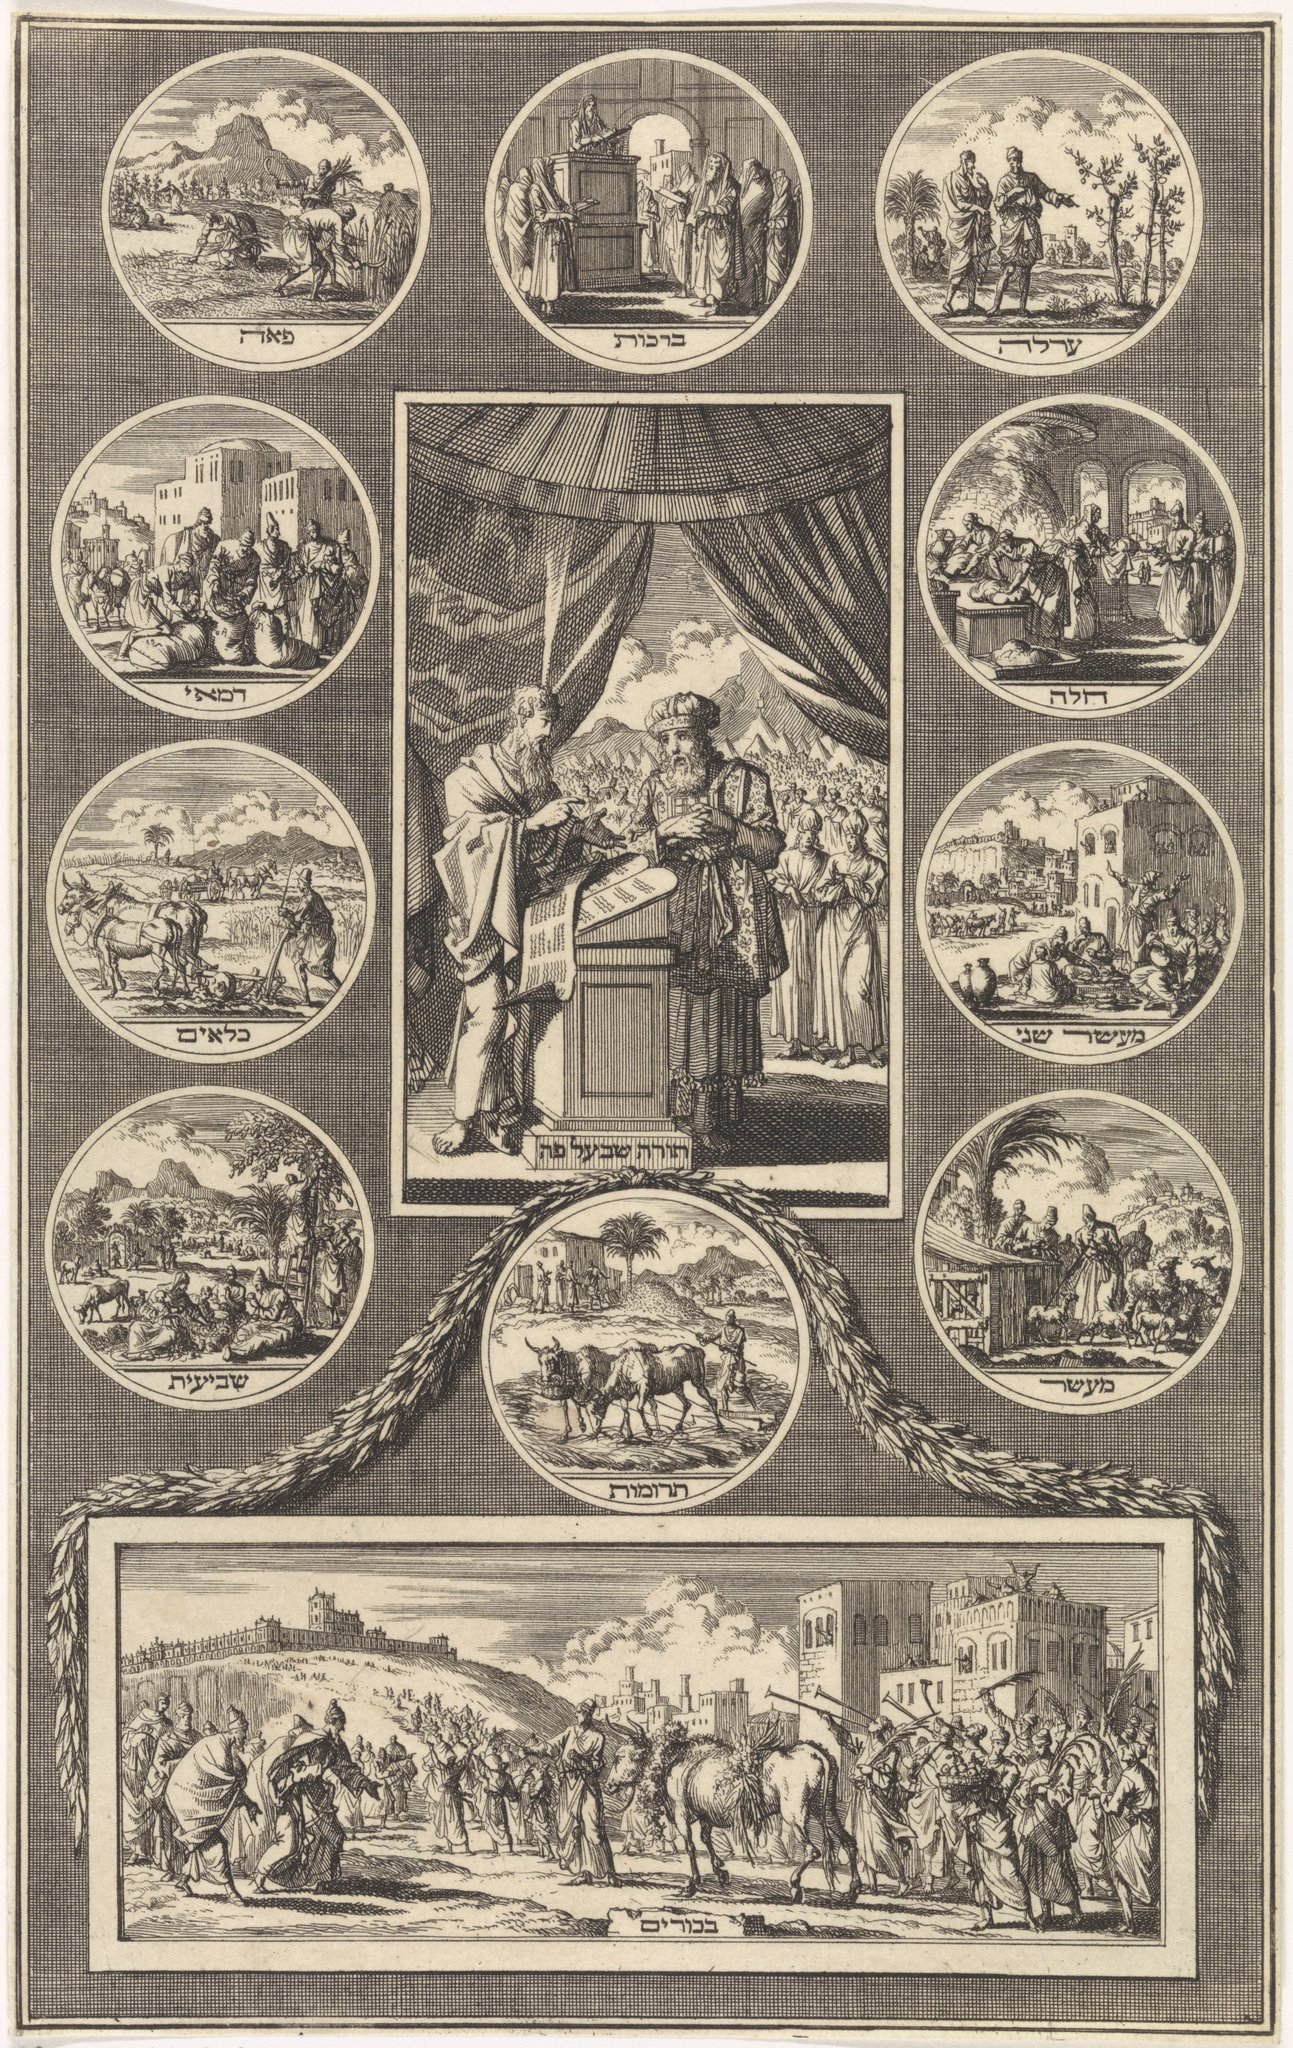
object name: print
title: Titelpagina voor: W. Surenhuys, Mischna sive Totius Hebræorum juris (...) systema, dl. I, 1698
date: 1698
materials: paper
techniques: etching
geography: amsterdam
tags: aaron (not in biblical context); possible attributes: attributes of aaron: censer, dressed as high priest or bishop, ointment jar, rod or flowering wand, moses (not in biblical context); possible attributes: rays of light or horns on his head, rod, tables of the law, sacrifice of animals ~ jewish religion, the new tables of the law (exodus 34), jewish religion and culture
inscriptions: collector's mark: Lugt 2228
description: Mozes verklaart Aäron de tafelen der wet. Rondom deze centrale scène staan tien medaillons met verschillende voorstellingen die betrekking hebben tot de Joodse godsdienst. Geheel onderaan een afbeelding van een offerstier die naar de tempel wordt geleid. Alle voorstellingen zijn voorzien van een Hebreeuws opschrift.